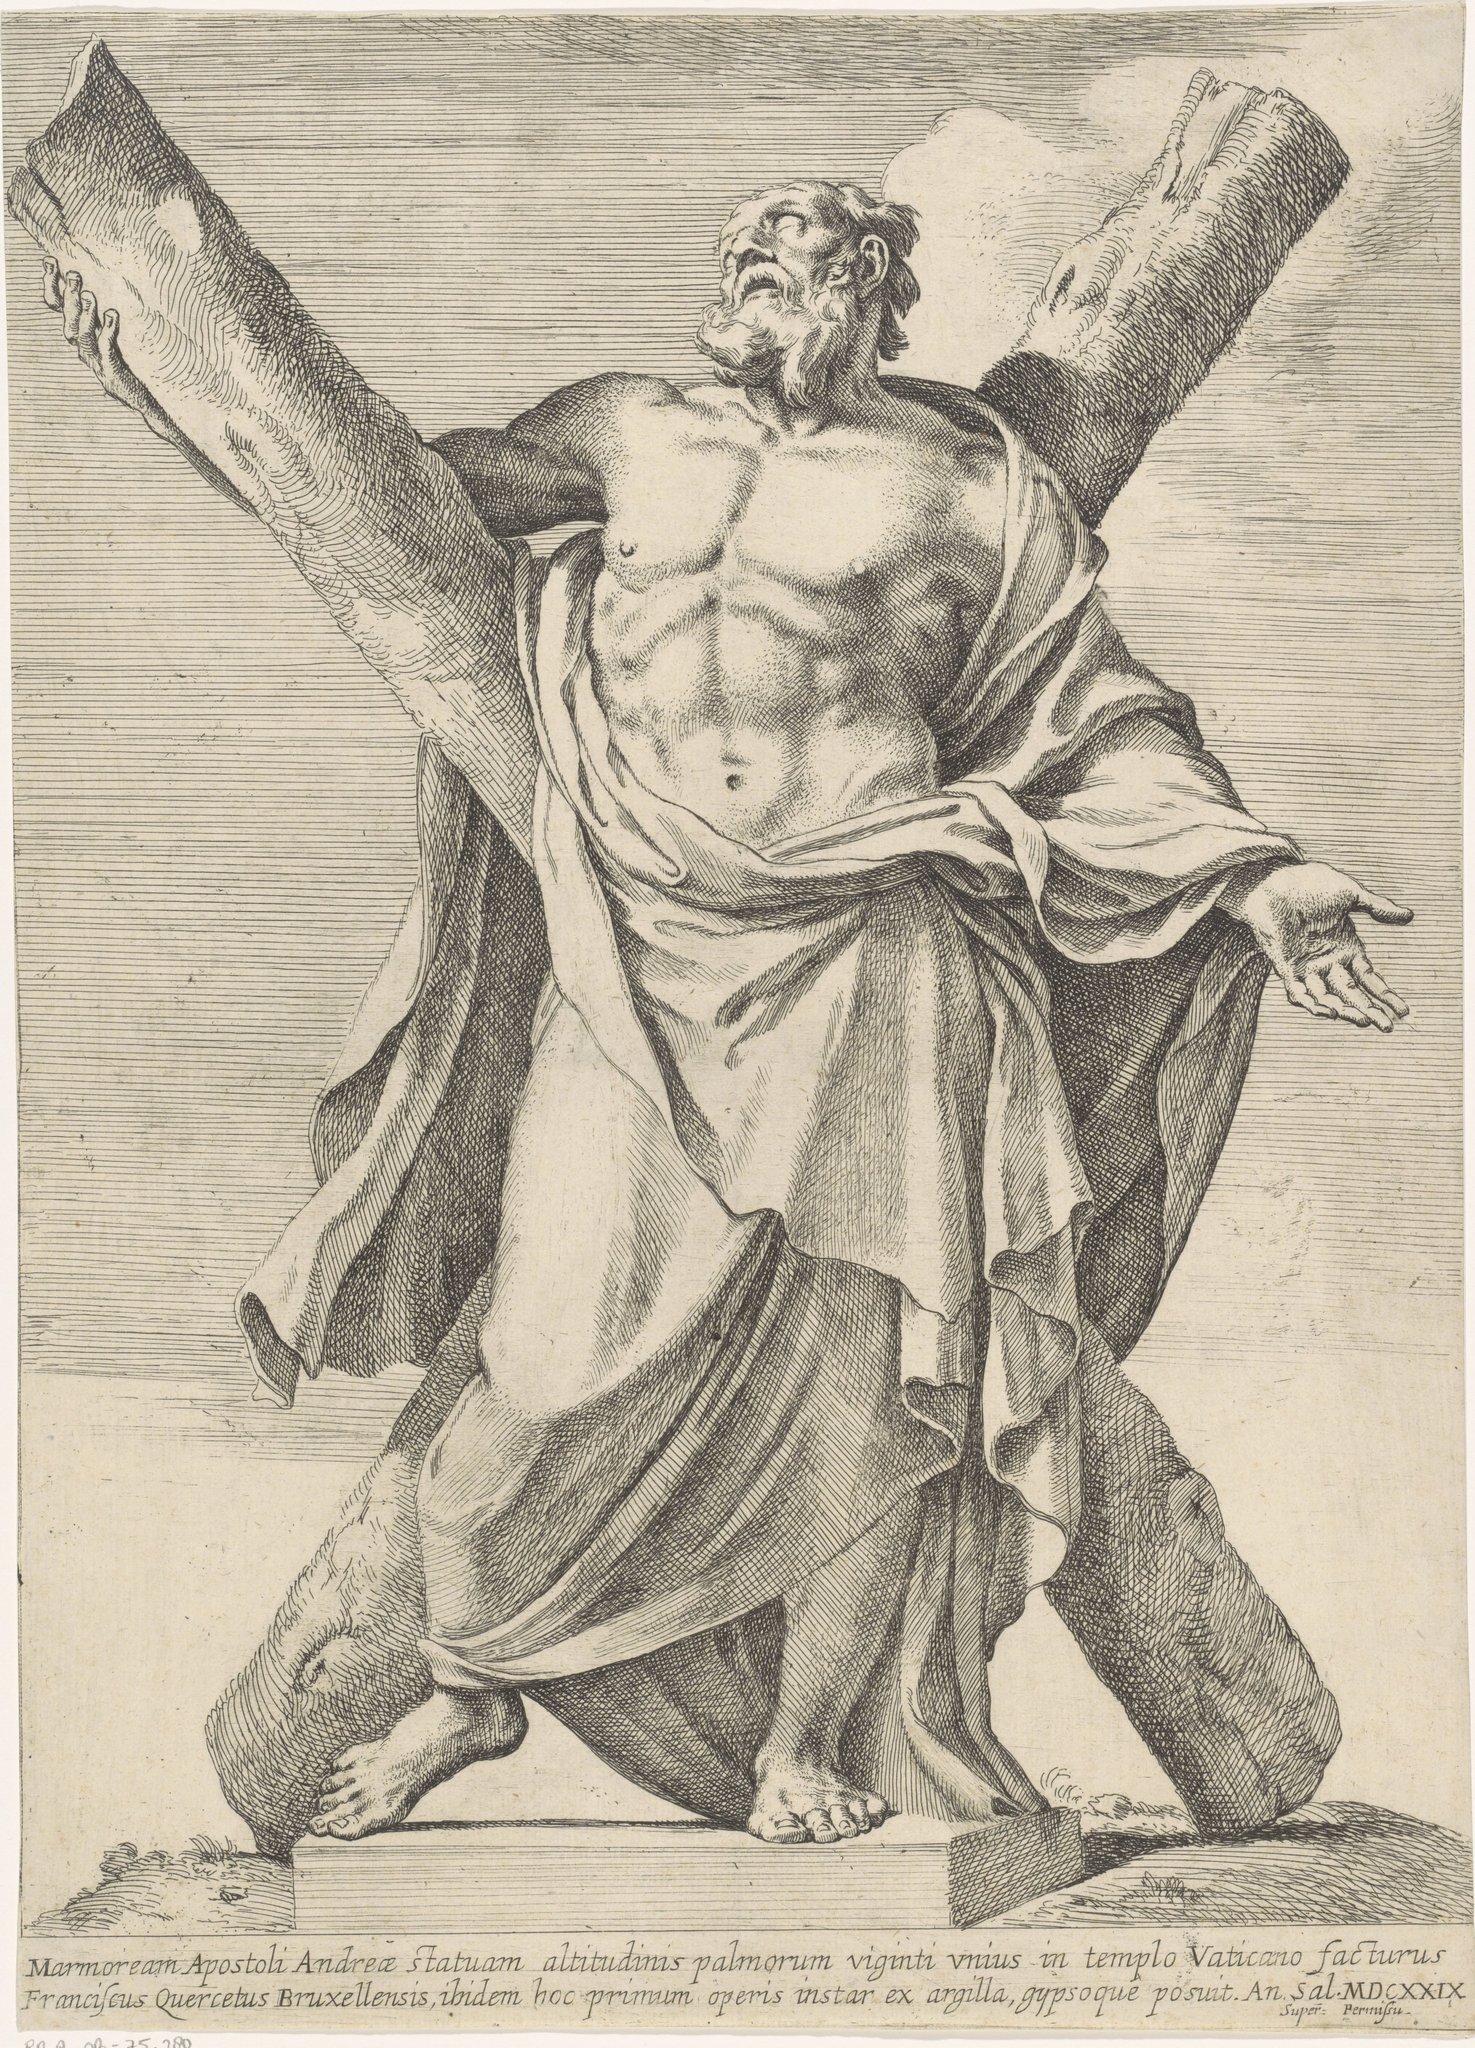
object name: print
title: H. Andreas met zijn kruis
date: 1629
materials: paper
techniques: etching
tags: the apostle andrew; possible attributes: book, x-shaped cross, fish, fishing-net, rope, scroll, piece of sculpture, reproduction of a piece of sculpture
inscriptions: collector's mark: Lugt 2228, collector's mark: Lugt 345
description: De heilige Andreas met zijn kruis. Naar het beeld in de Sint Pieter in Vaticaanstad. Onder de voorstelling een tweeregelige tekst in het Latijn.